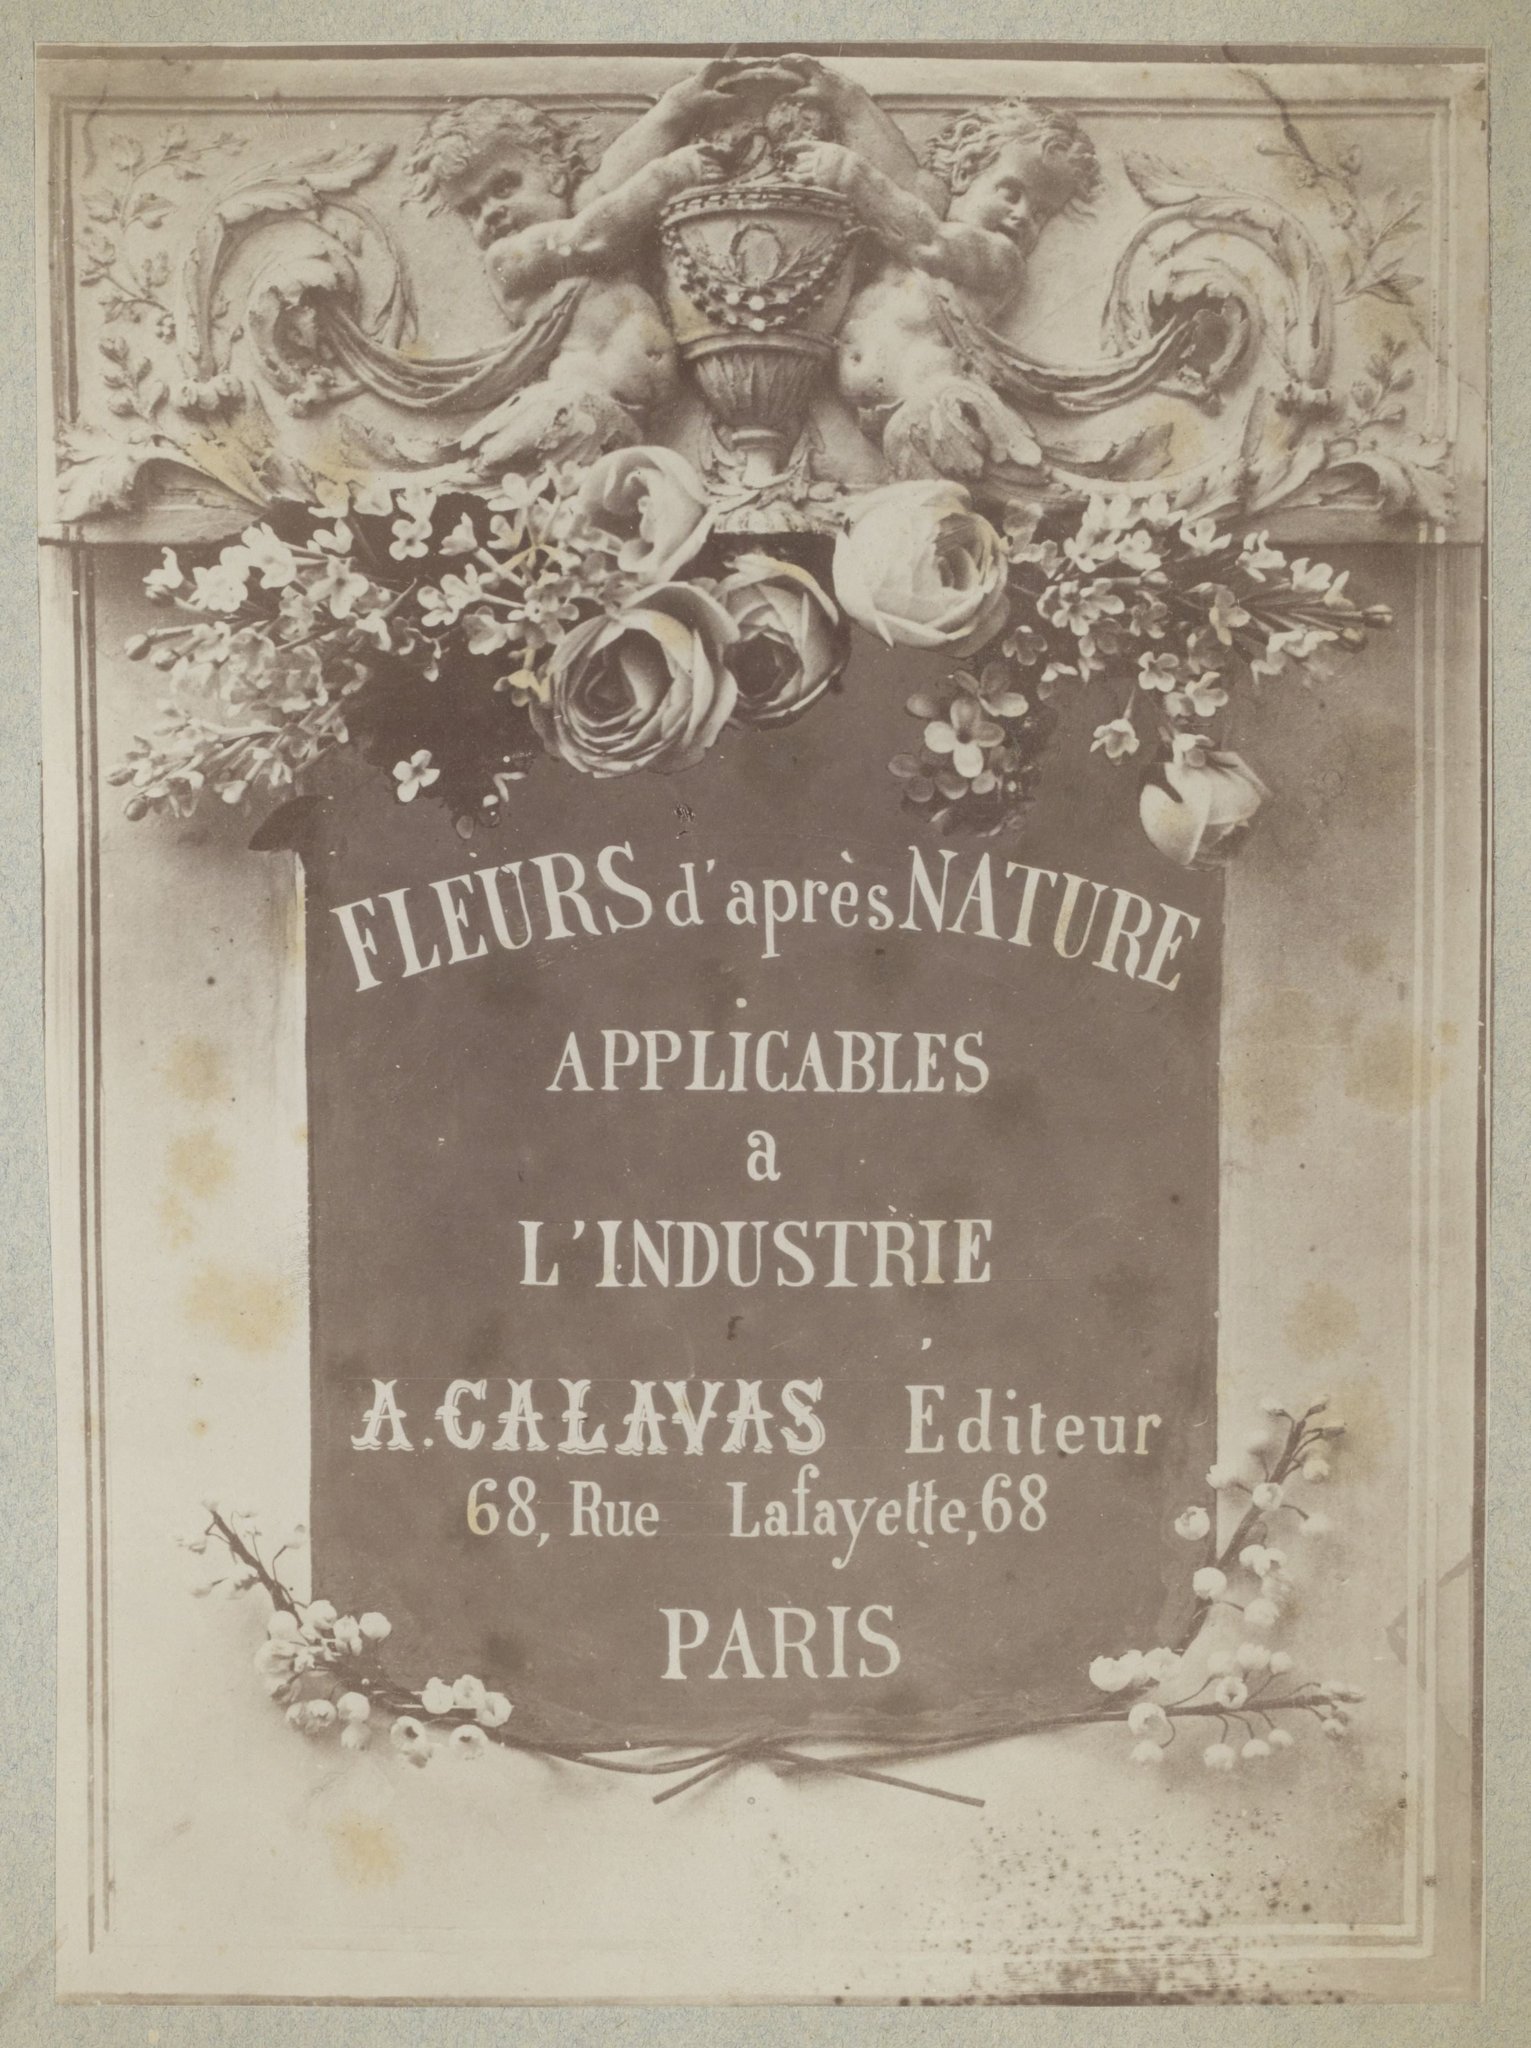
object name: titelblad, titelpagina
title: Titelpagina van Fleurs d’après Nature applicables à l’Industrie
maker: a. calavas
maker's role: publisher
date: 1875-1895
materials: cardboard, photographic support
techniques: albumen print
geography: paris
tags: flowers, sculpture (+ relief ~ sculpture)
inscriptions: collector's mark: Lugt 3937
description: Onderdeel van Verzamelband met foto's van bloemstudies.